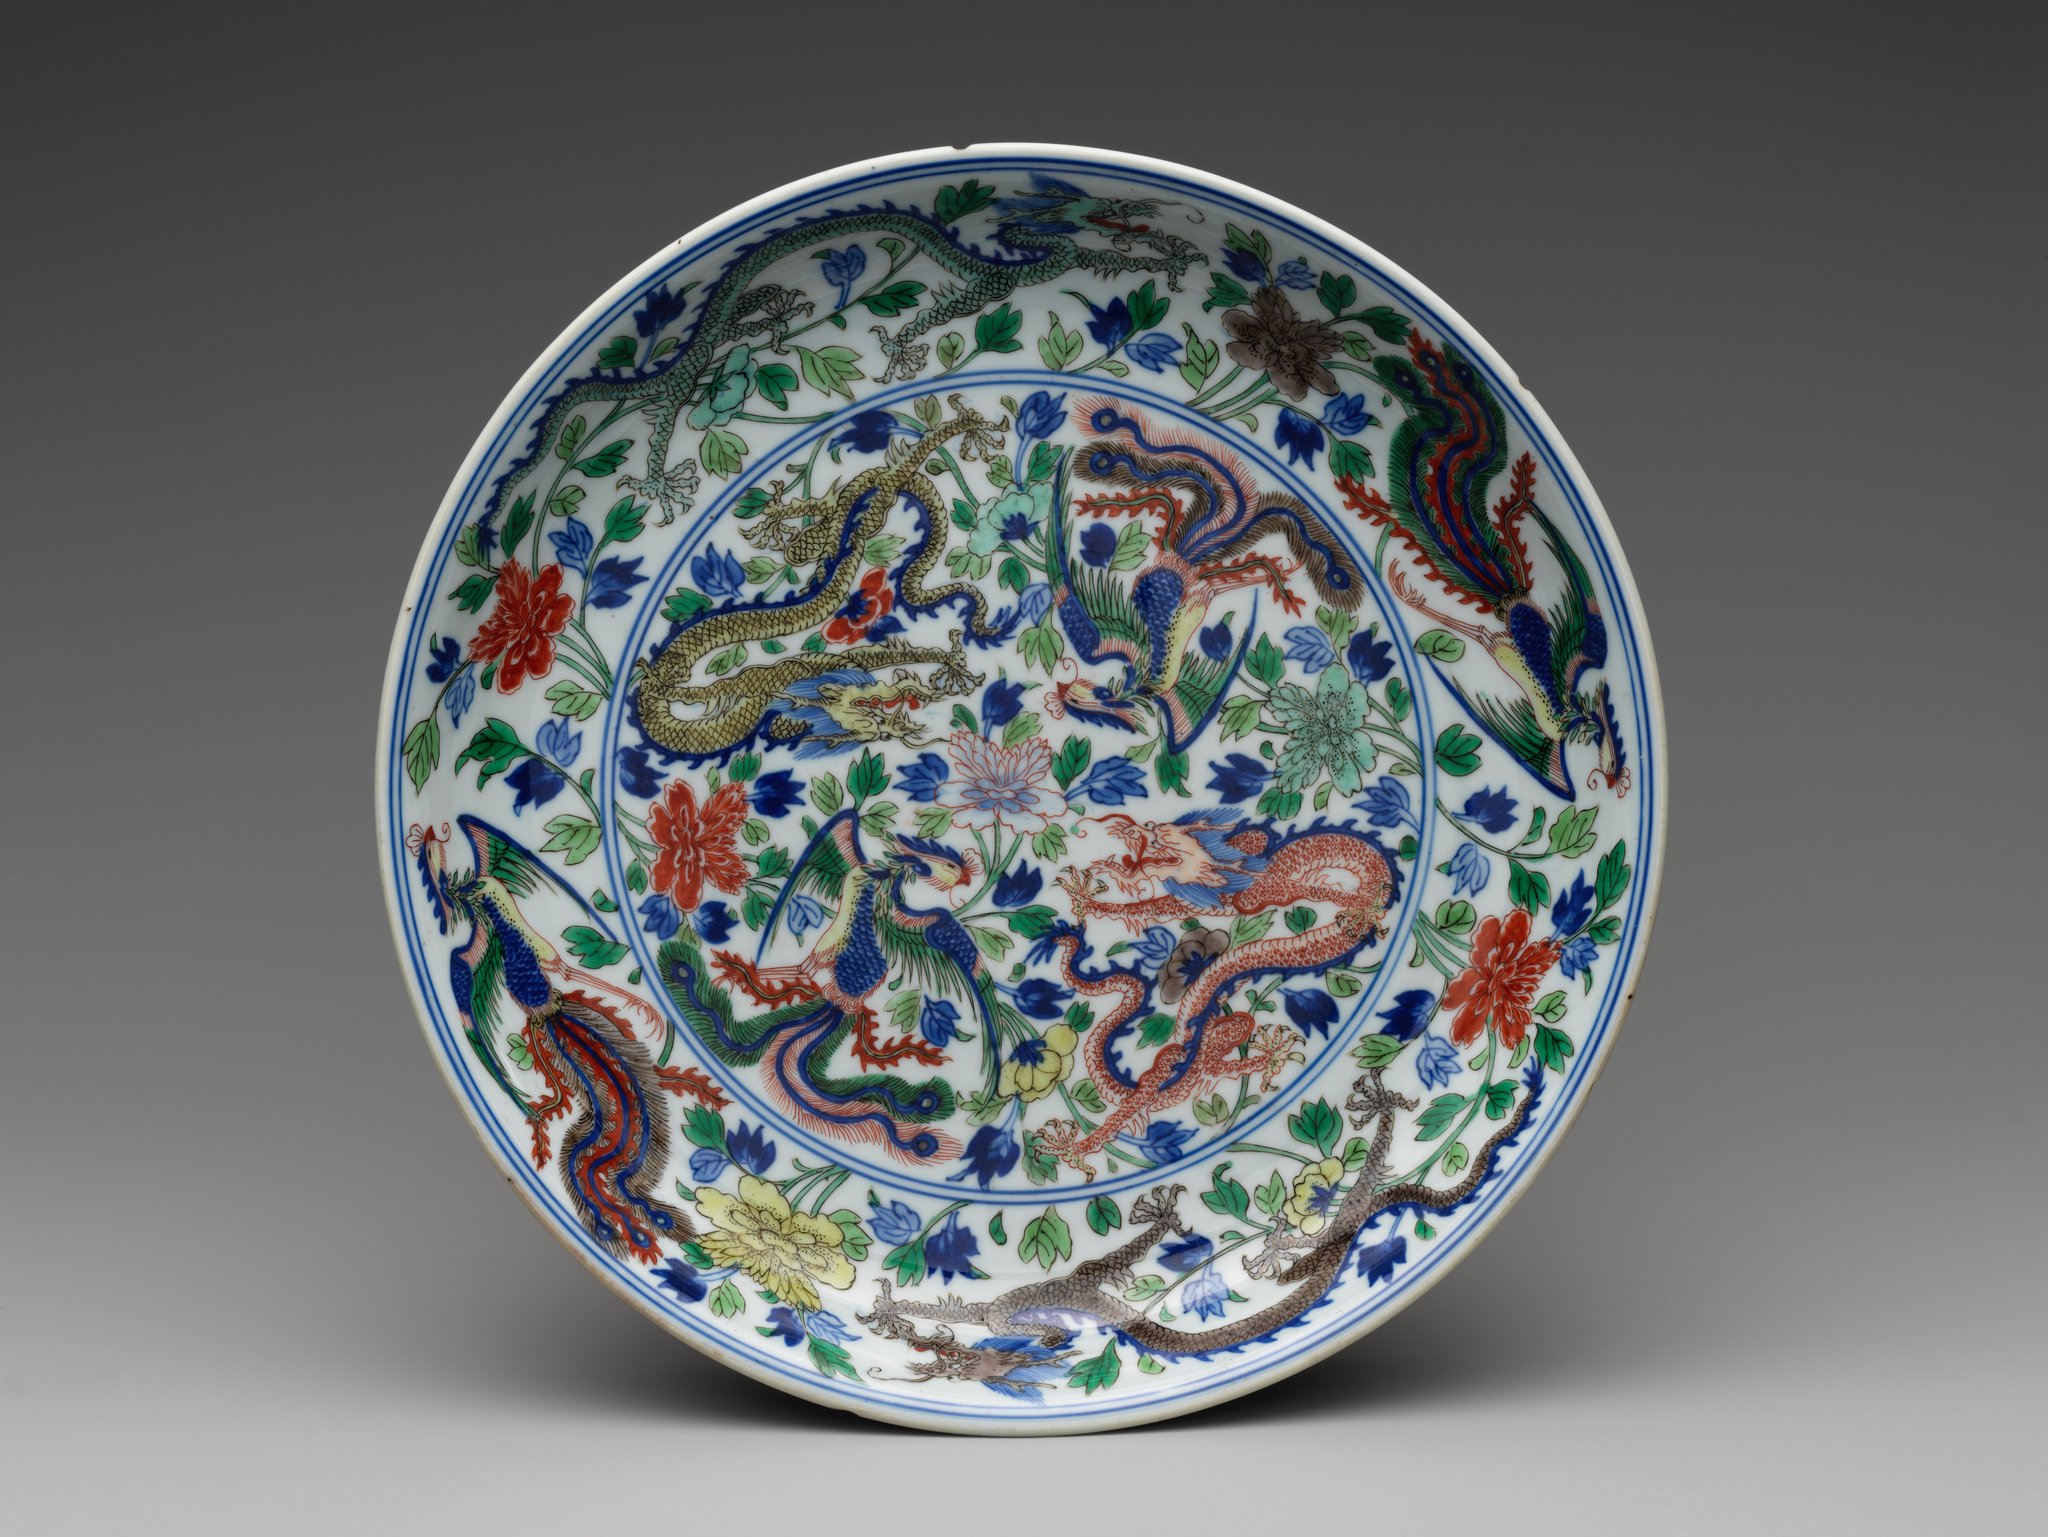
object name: dish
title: Dish with dragons and phoenixes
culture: chinese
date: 1701-1733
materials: cobalt, enamel, porcelain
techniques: overglaze, painting, polychrome, underglaze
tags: dragons,phoenix